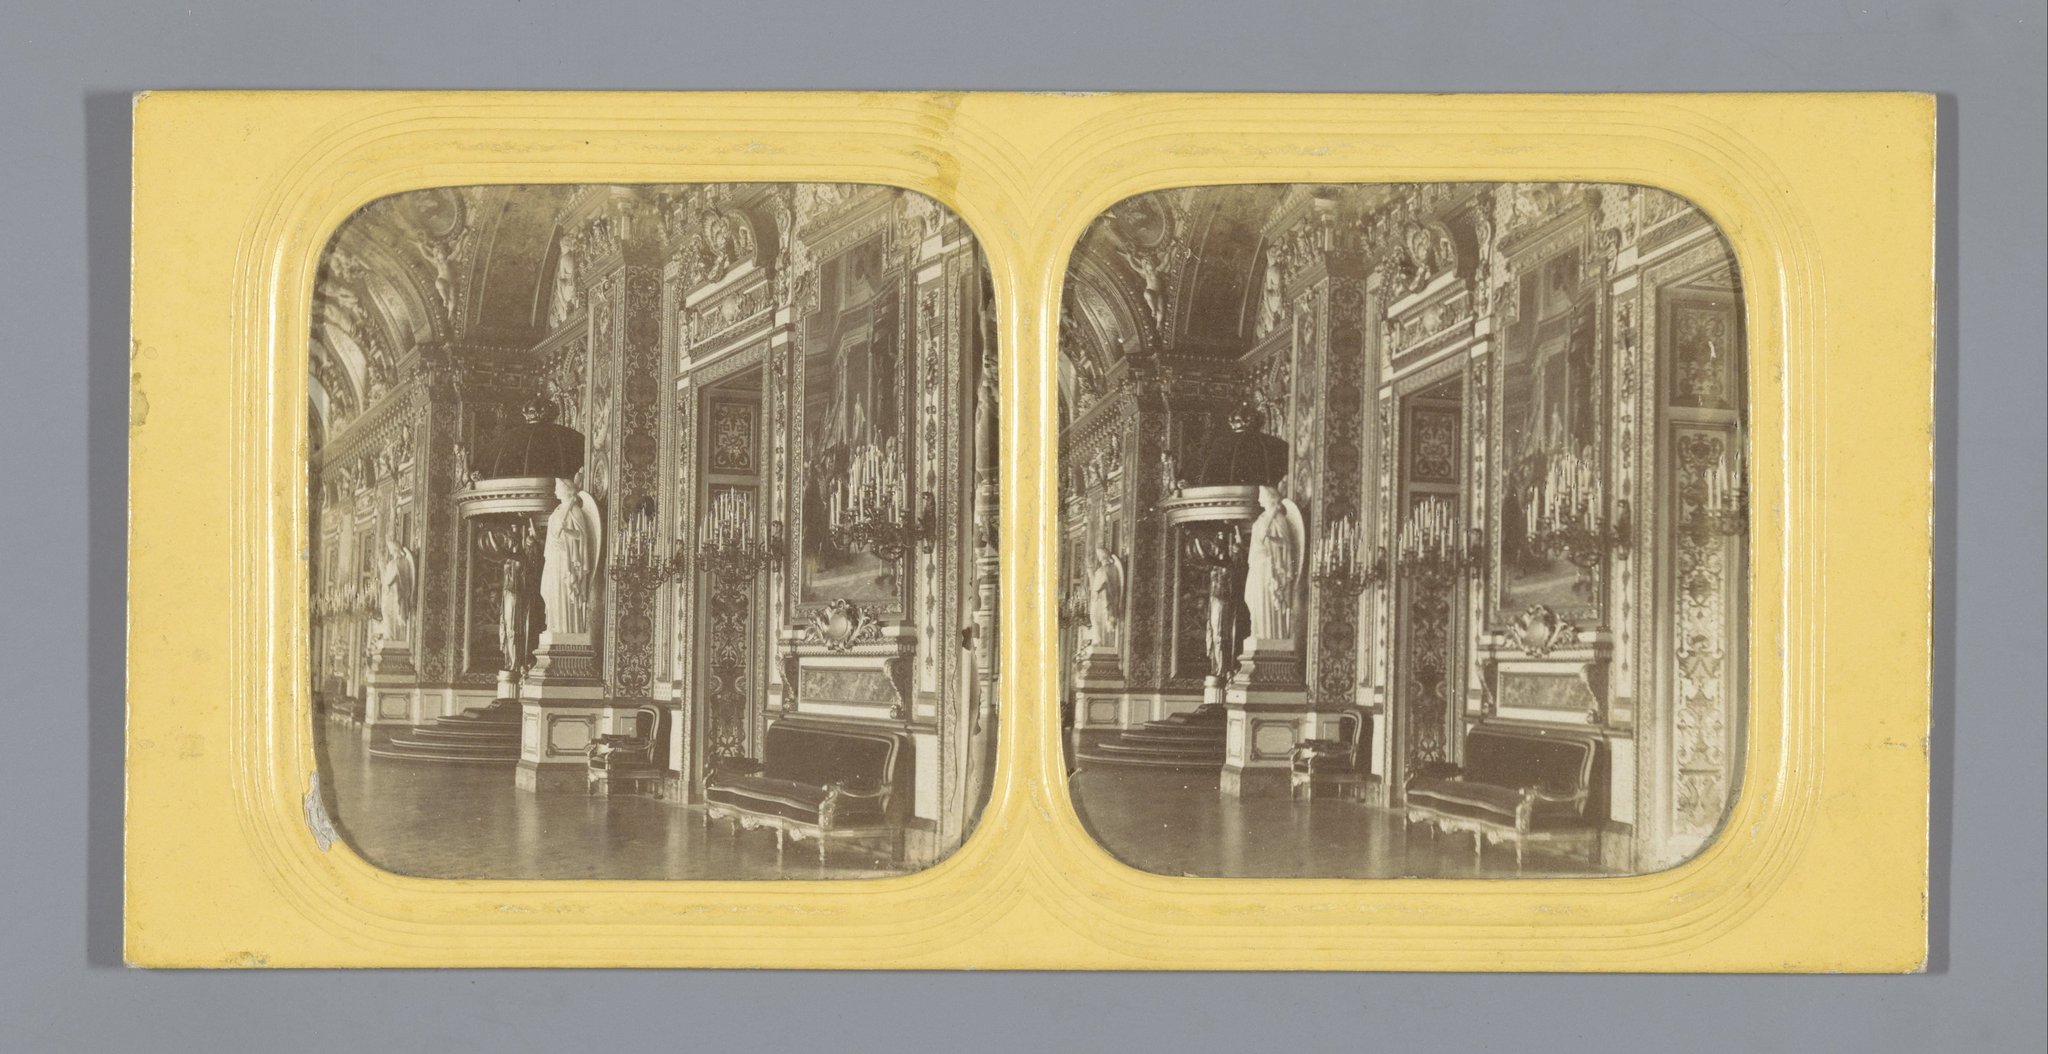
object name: tissue stereograph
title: Salle du Trône, Senat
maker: Anonymous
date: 1855-1875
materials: cardboard, paper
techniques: albumen print, hand coloring, perforating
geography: paris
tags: throne-room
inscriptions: retailer's mark: ‘Au Jardin des Tuileries/ 202, rue de Rivoli./ B. Guérard,/ Grand assortimt. de stéréoscopes et vues/ stéréoscopiques de tous pays; albums illustrés./ Portraits cartes, papeterie encadremts. en piemes’